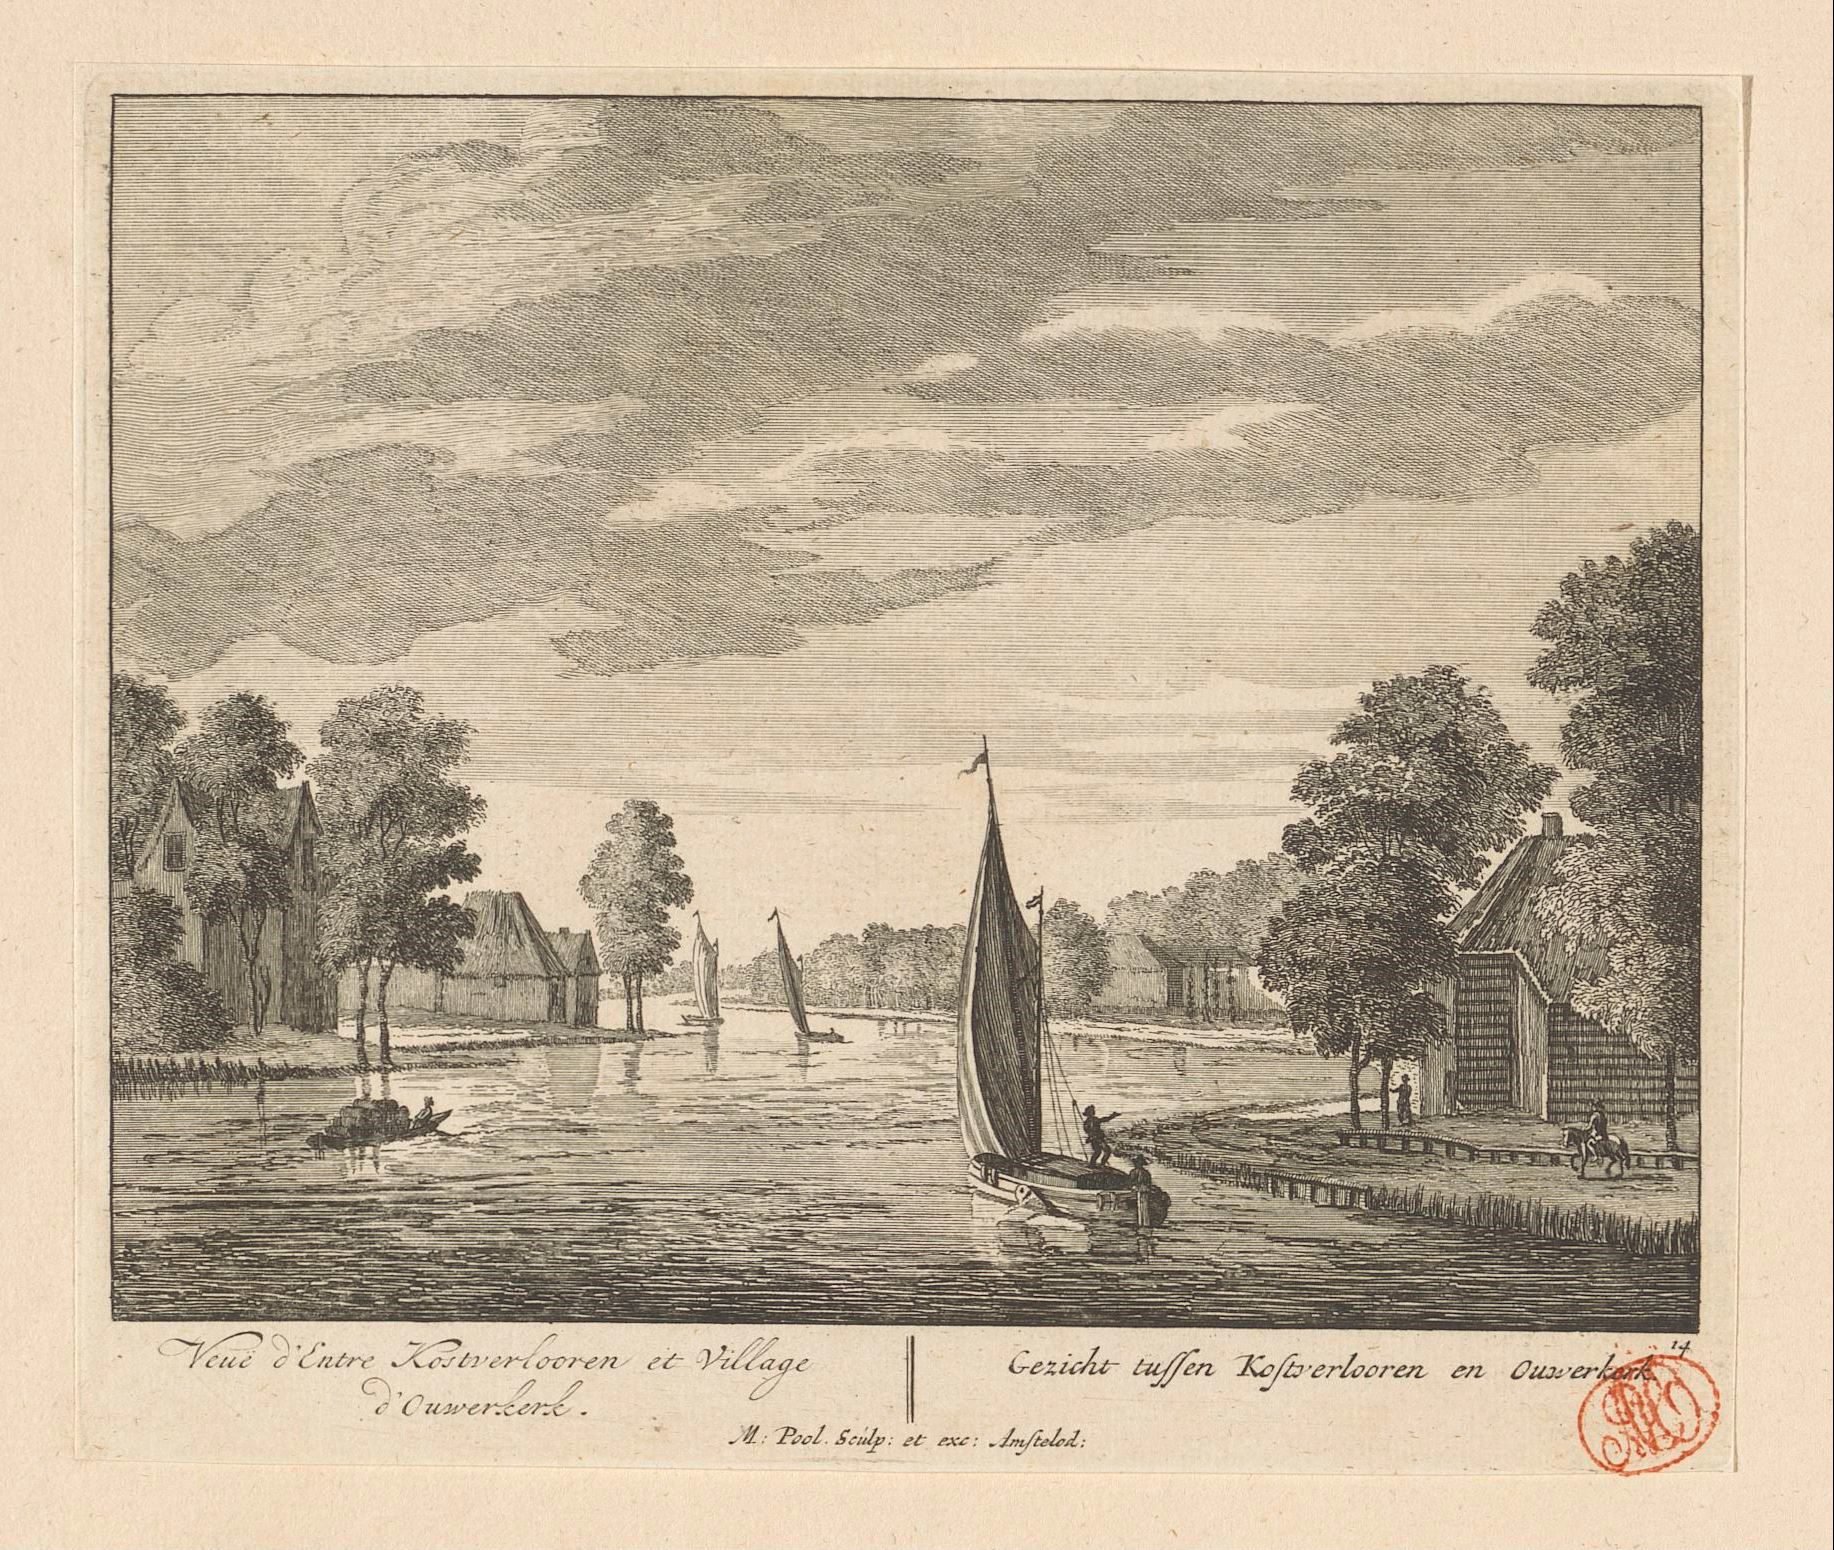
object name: print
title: Gezicht op de Amstel tussen hofstede Kostverloren en Ouderkerk aan de Amstel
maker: matthijs pool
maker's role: print maker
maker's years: 1676-1740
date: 1708-1740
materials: paper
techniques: engraving, etching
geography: amsterdam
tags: sailing-ship, sailing-boat, river, rowing-boat, canoe, etc.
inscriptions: collector's mark: Lugt 2233, collector's mark: Lugt 195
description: Prent gebruikt in: Pool, Matthijs. Verscheyde gesigten van de vermaarde rievier de buyten Amstel van de stadt Amsterdam, tot het dorp Ouwerkerk (…) / Plusieurs veuës et perspectives de la fameuse riviére de Buyten-Amstel depuis Amsterdam jusqu'au village d'Ouwerkerk (…). Amsterdam: Matthijs Pool, z.j. [1708-1740].